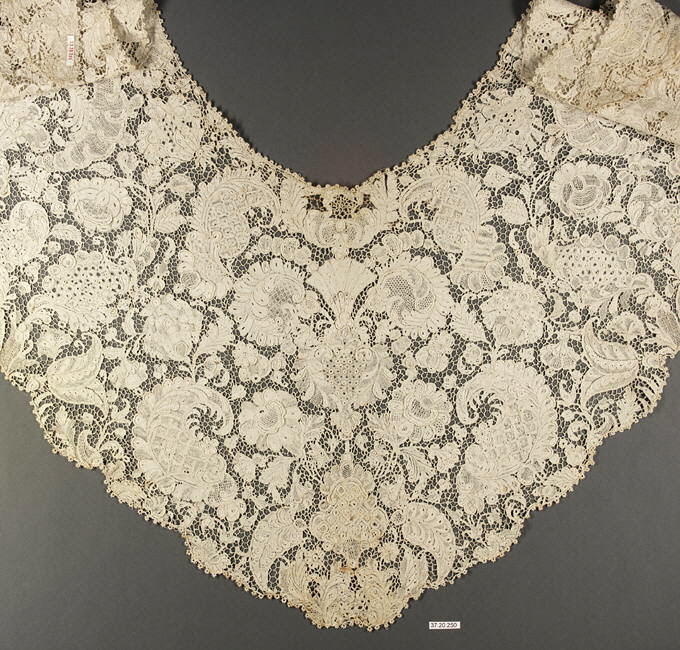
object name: collar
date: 1701-1800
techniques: lace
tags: flowers